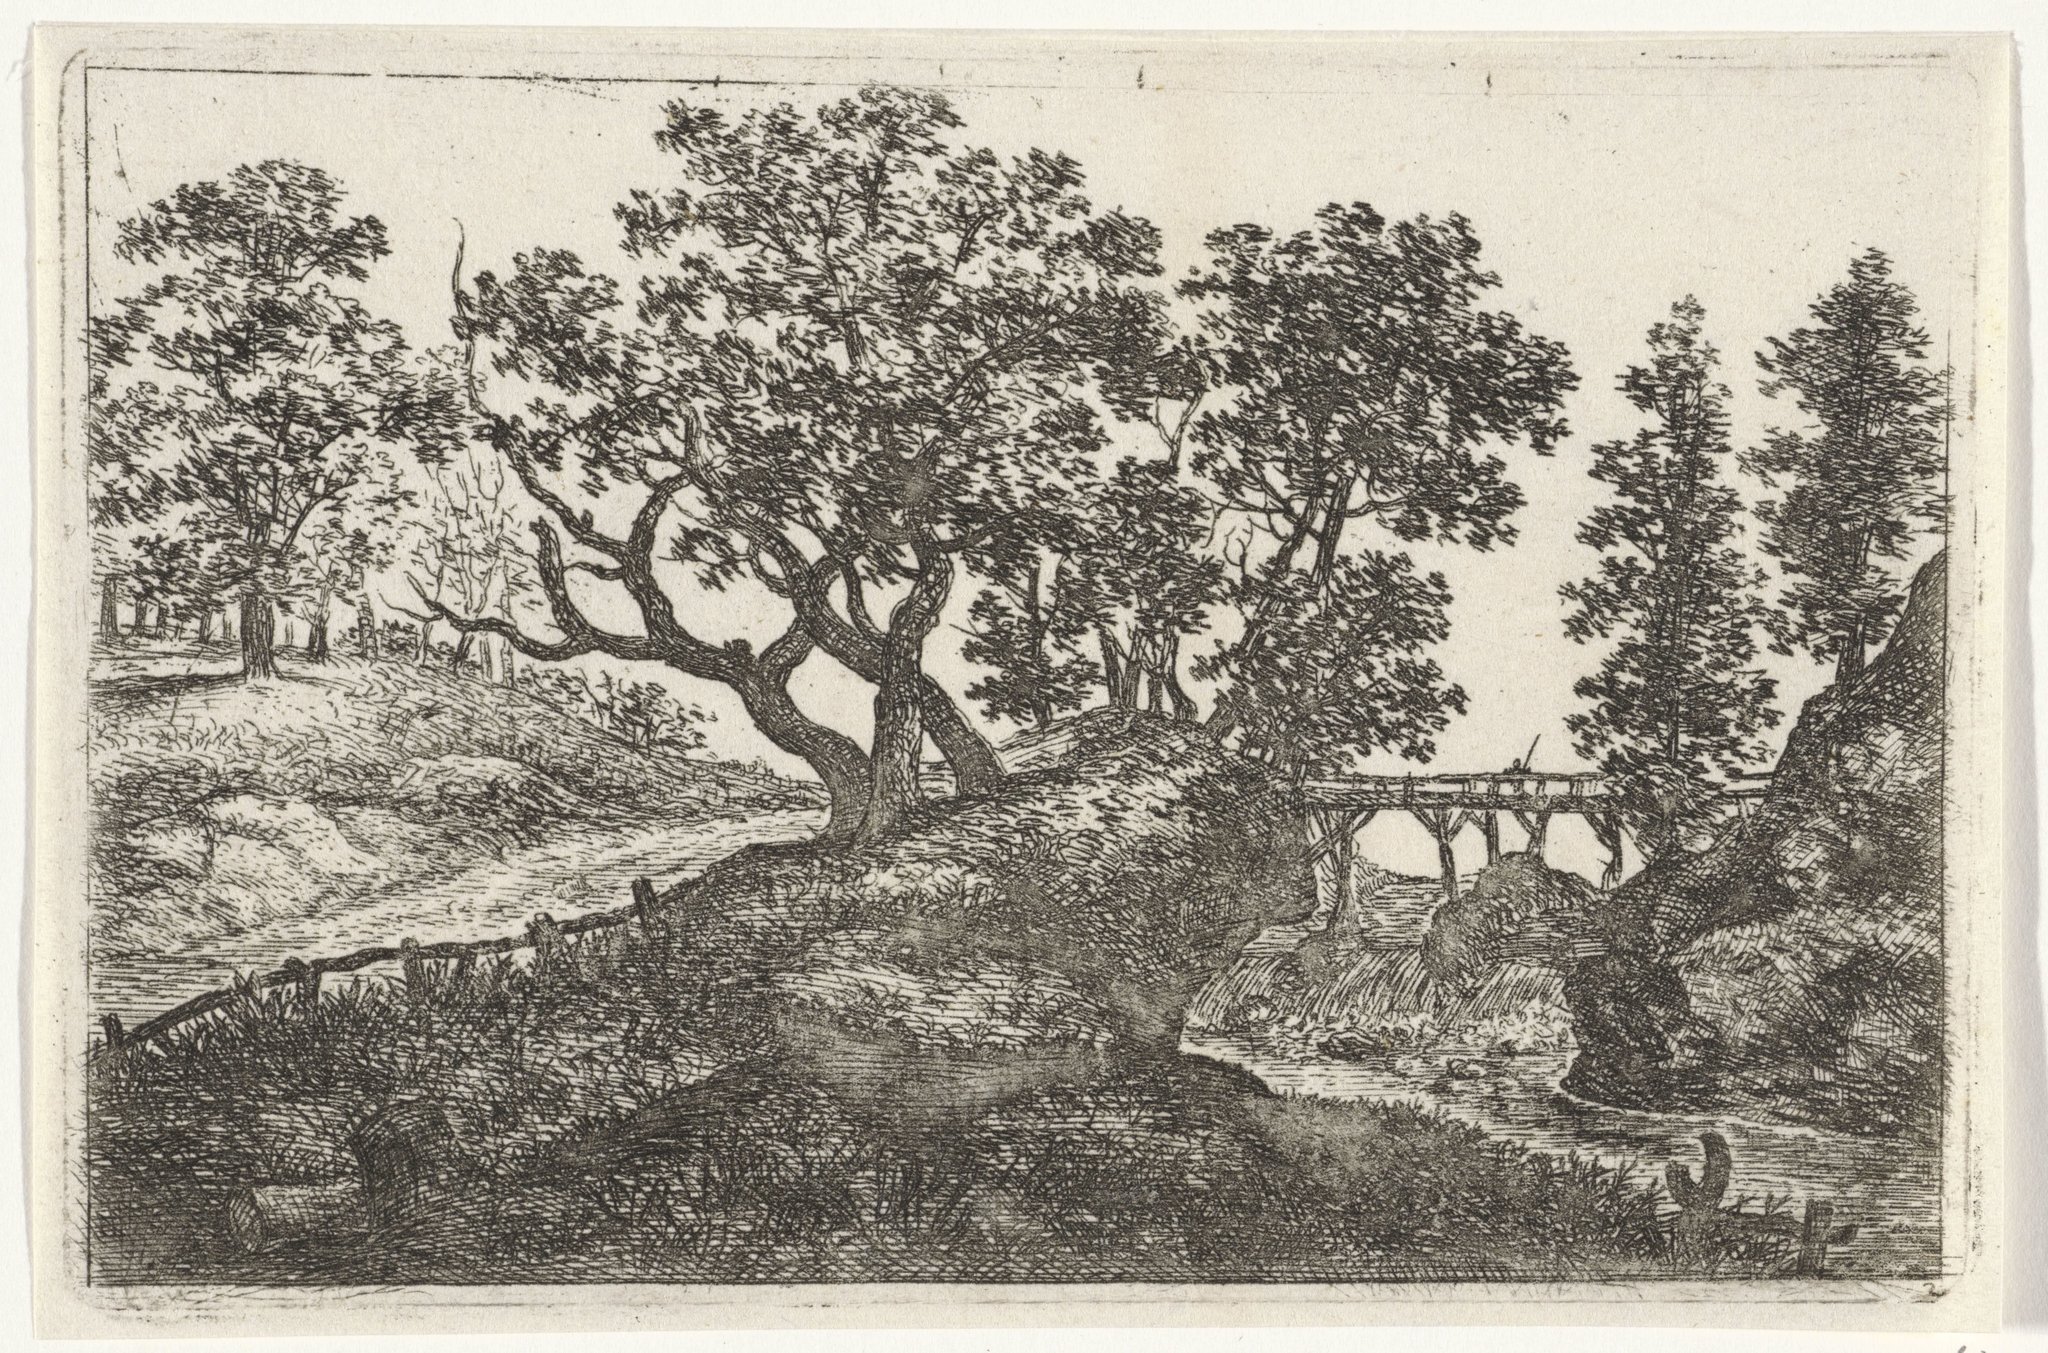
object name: print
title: Landschap met een houten brug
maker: jean vaillant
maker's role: print maker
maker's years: 1627-1668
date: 1637-1674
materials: paper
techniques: etching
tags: landscape with bridge, viaduct or aqueduct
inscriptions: collector's mark: Lugt 2288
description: Landschap met bomen en een rivier waarover een houten brug. Tweede prent uit een serie van zes prenten met landschappen.